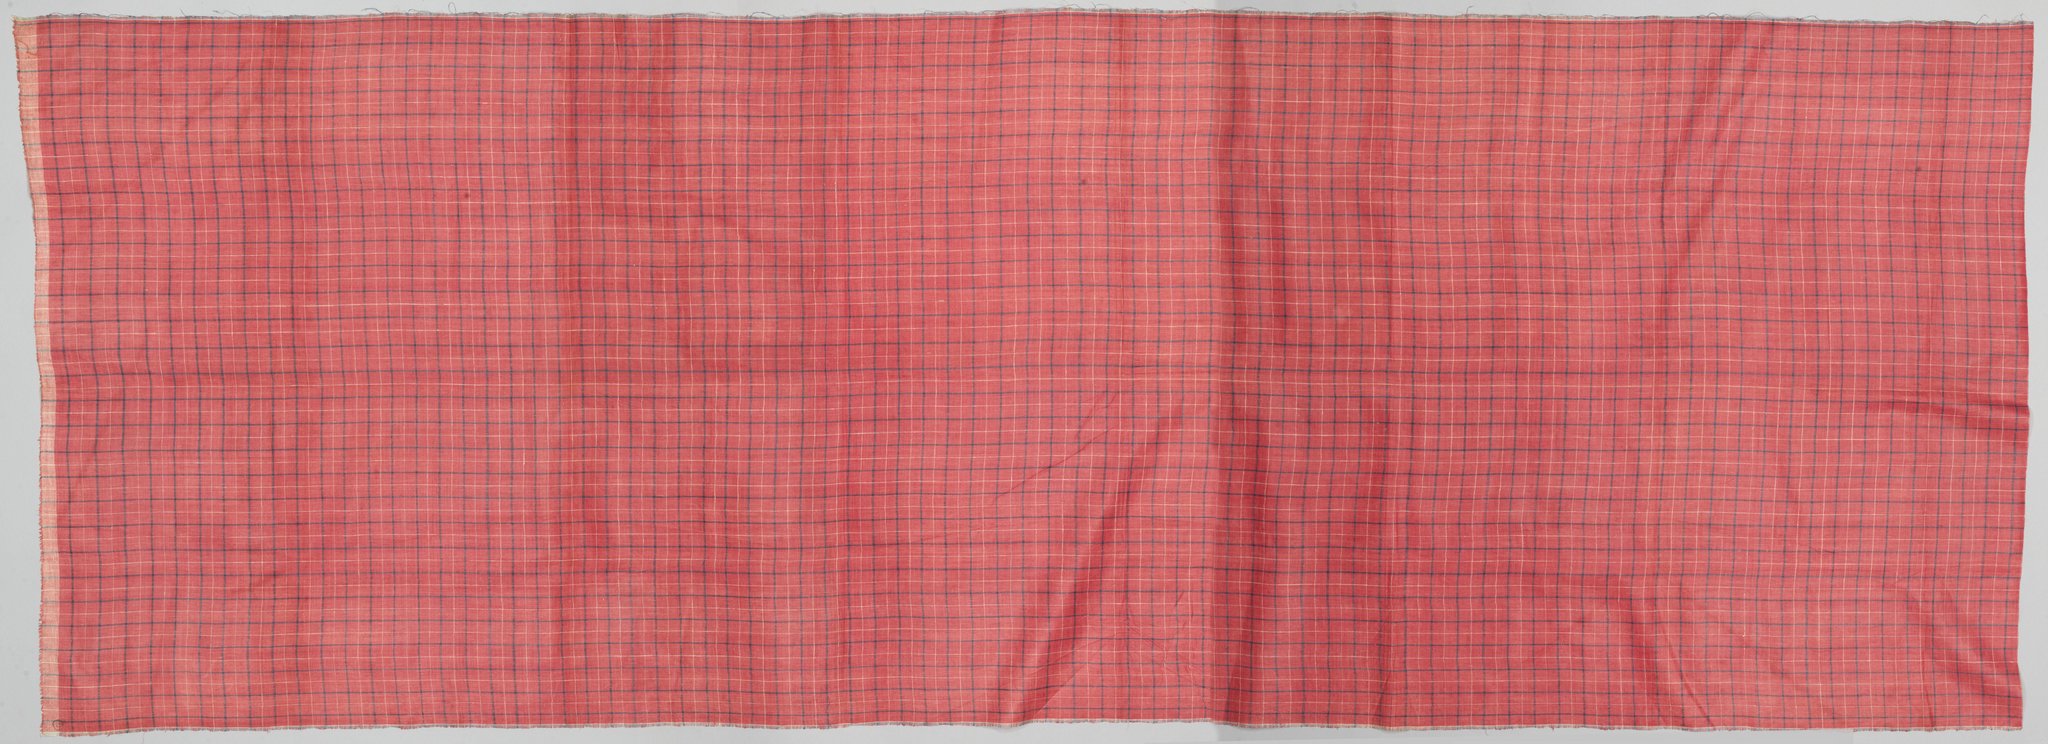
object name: lining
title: Fragment celas, rode geruite voeringstof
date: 1750-1800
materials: cotton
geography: east indies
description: Fragment celas, rood fond met blauw-witte ruit Calas no. 4. Stukgoed.